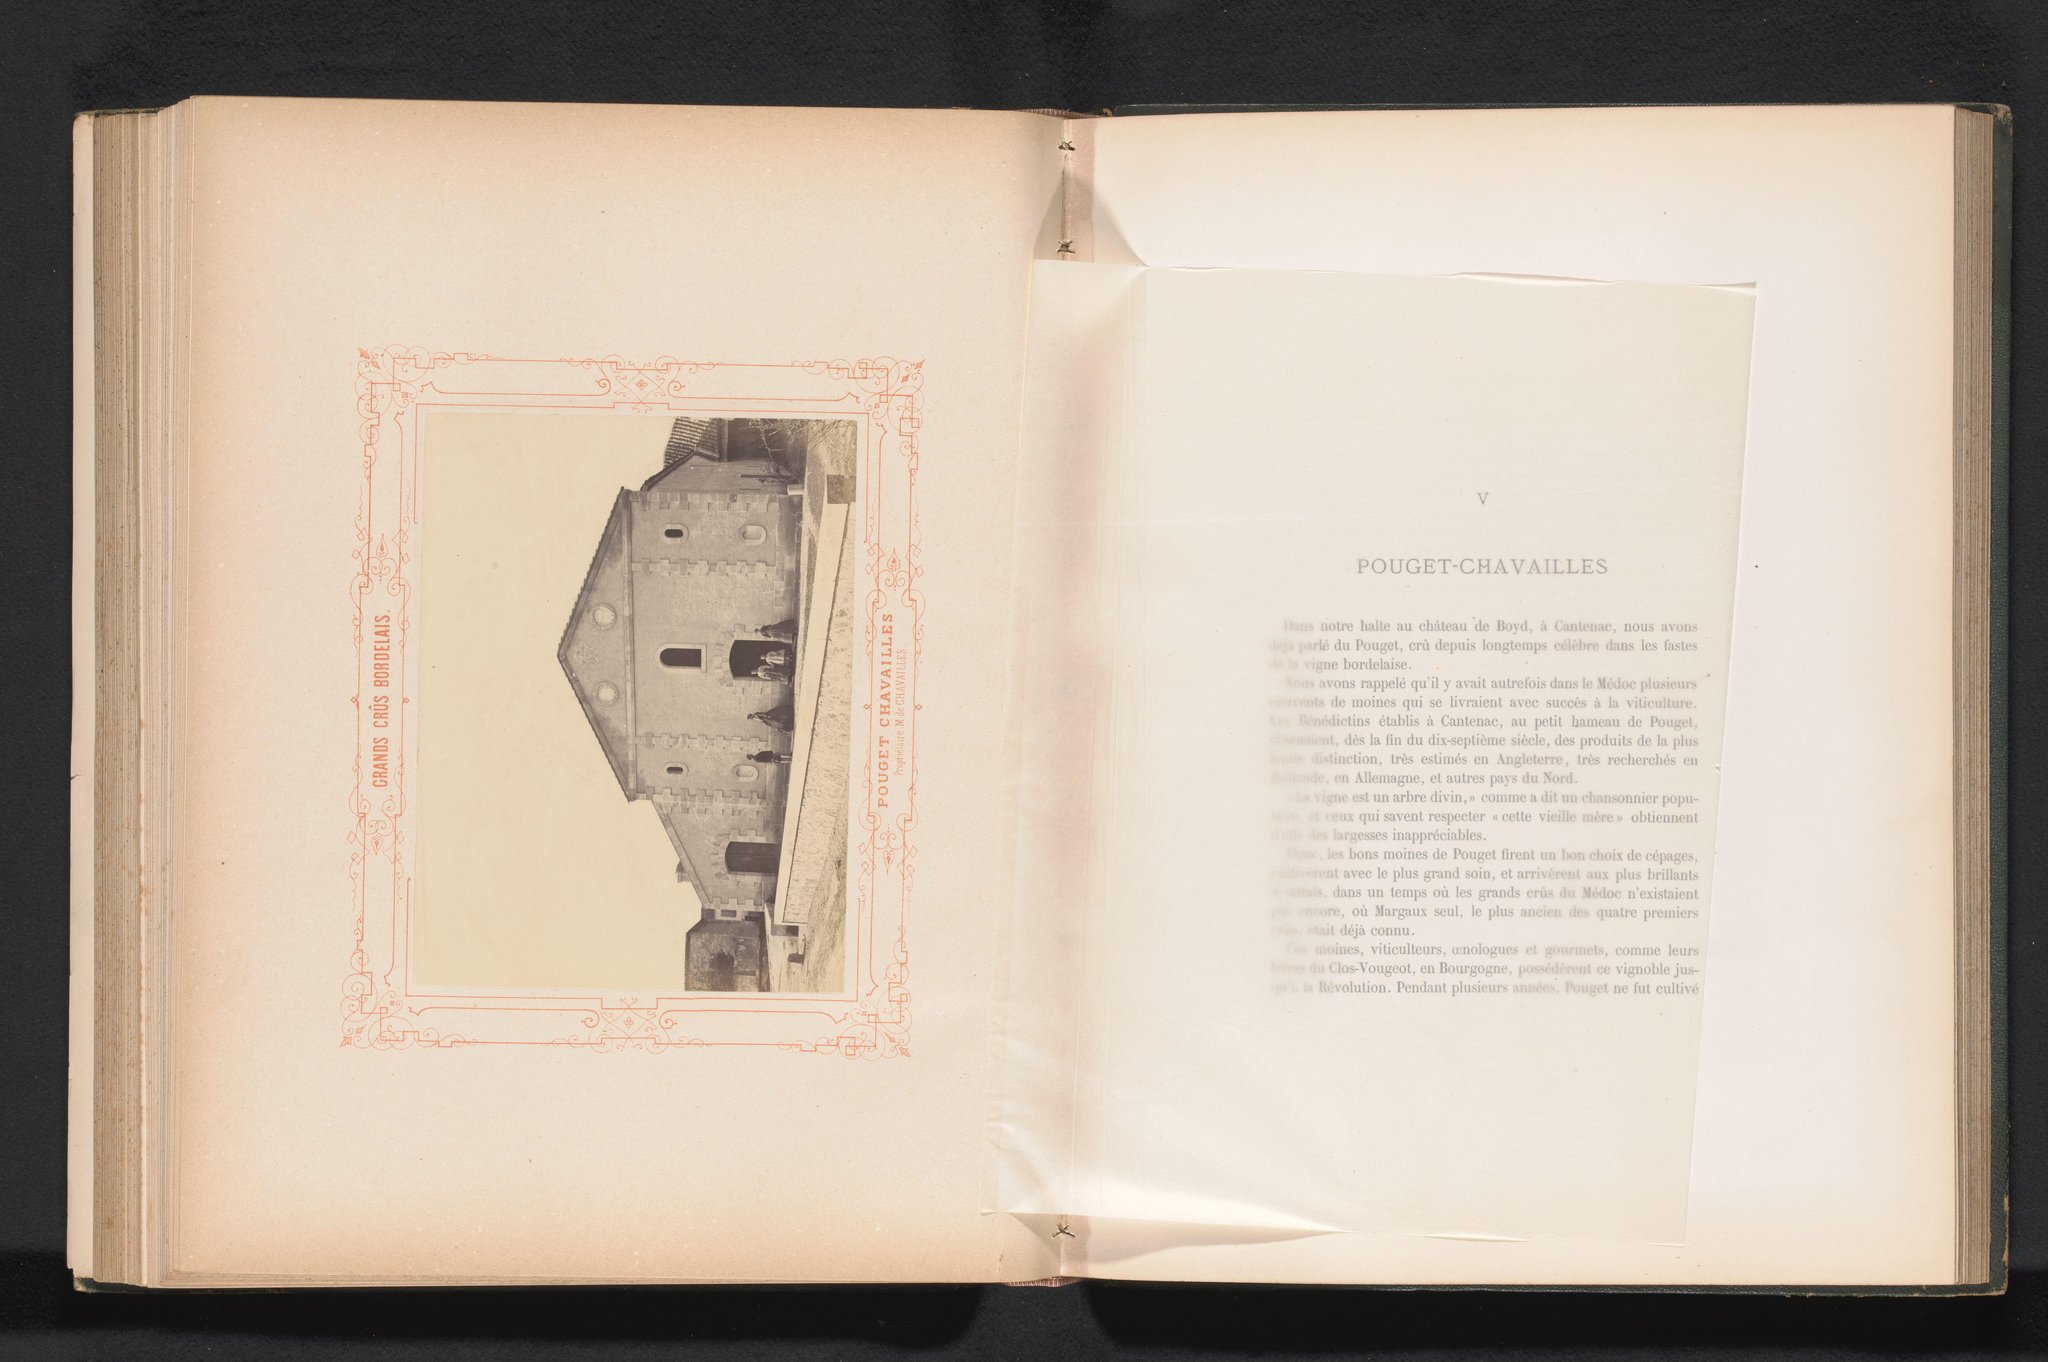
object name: page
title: Grands Crûs Bordelais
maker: alfred danflou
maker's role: fotograaf, schrijver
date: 1862-1867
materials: photographic support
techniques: albumen print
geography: margaux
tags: castle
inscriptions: inscription: ‘Propriétaire: M. de CHAVAILLES.’